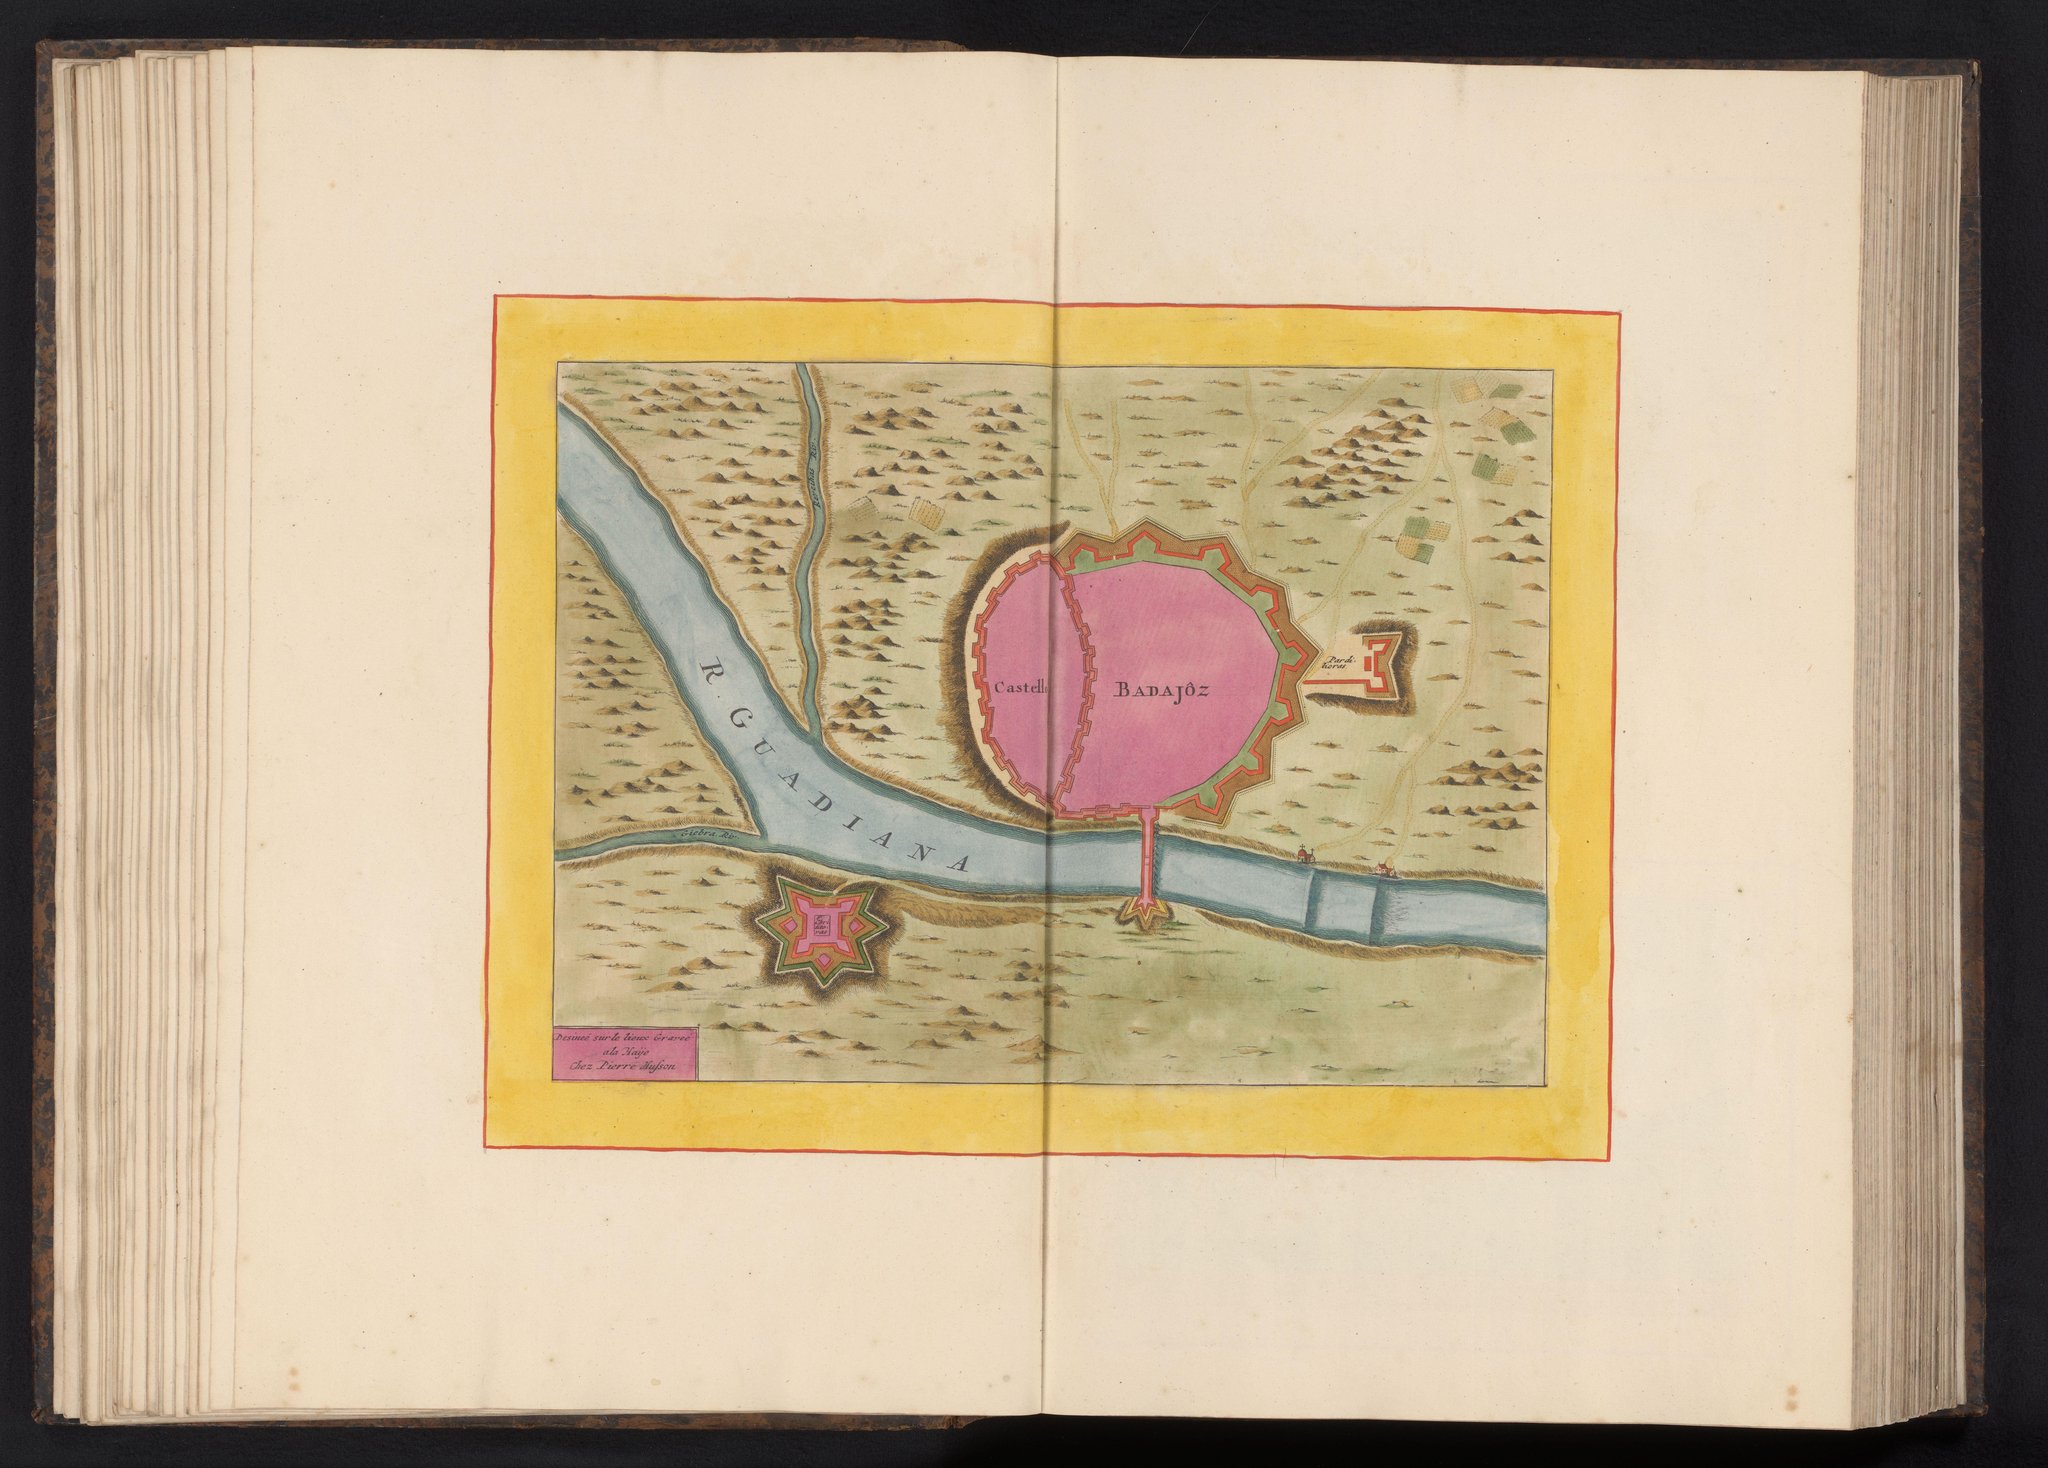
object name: album leaf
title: Plattegrond van Badajoz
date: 1703-1732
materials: paper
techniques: etching, hand coloring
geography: the hague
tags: fortress, river, maps of cities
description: Plattegrond van de stad Badajoz aan de rivier Guadiana. Prent maakt deel uit van een album.